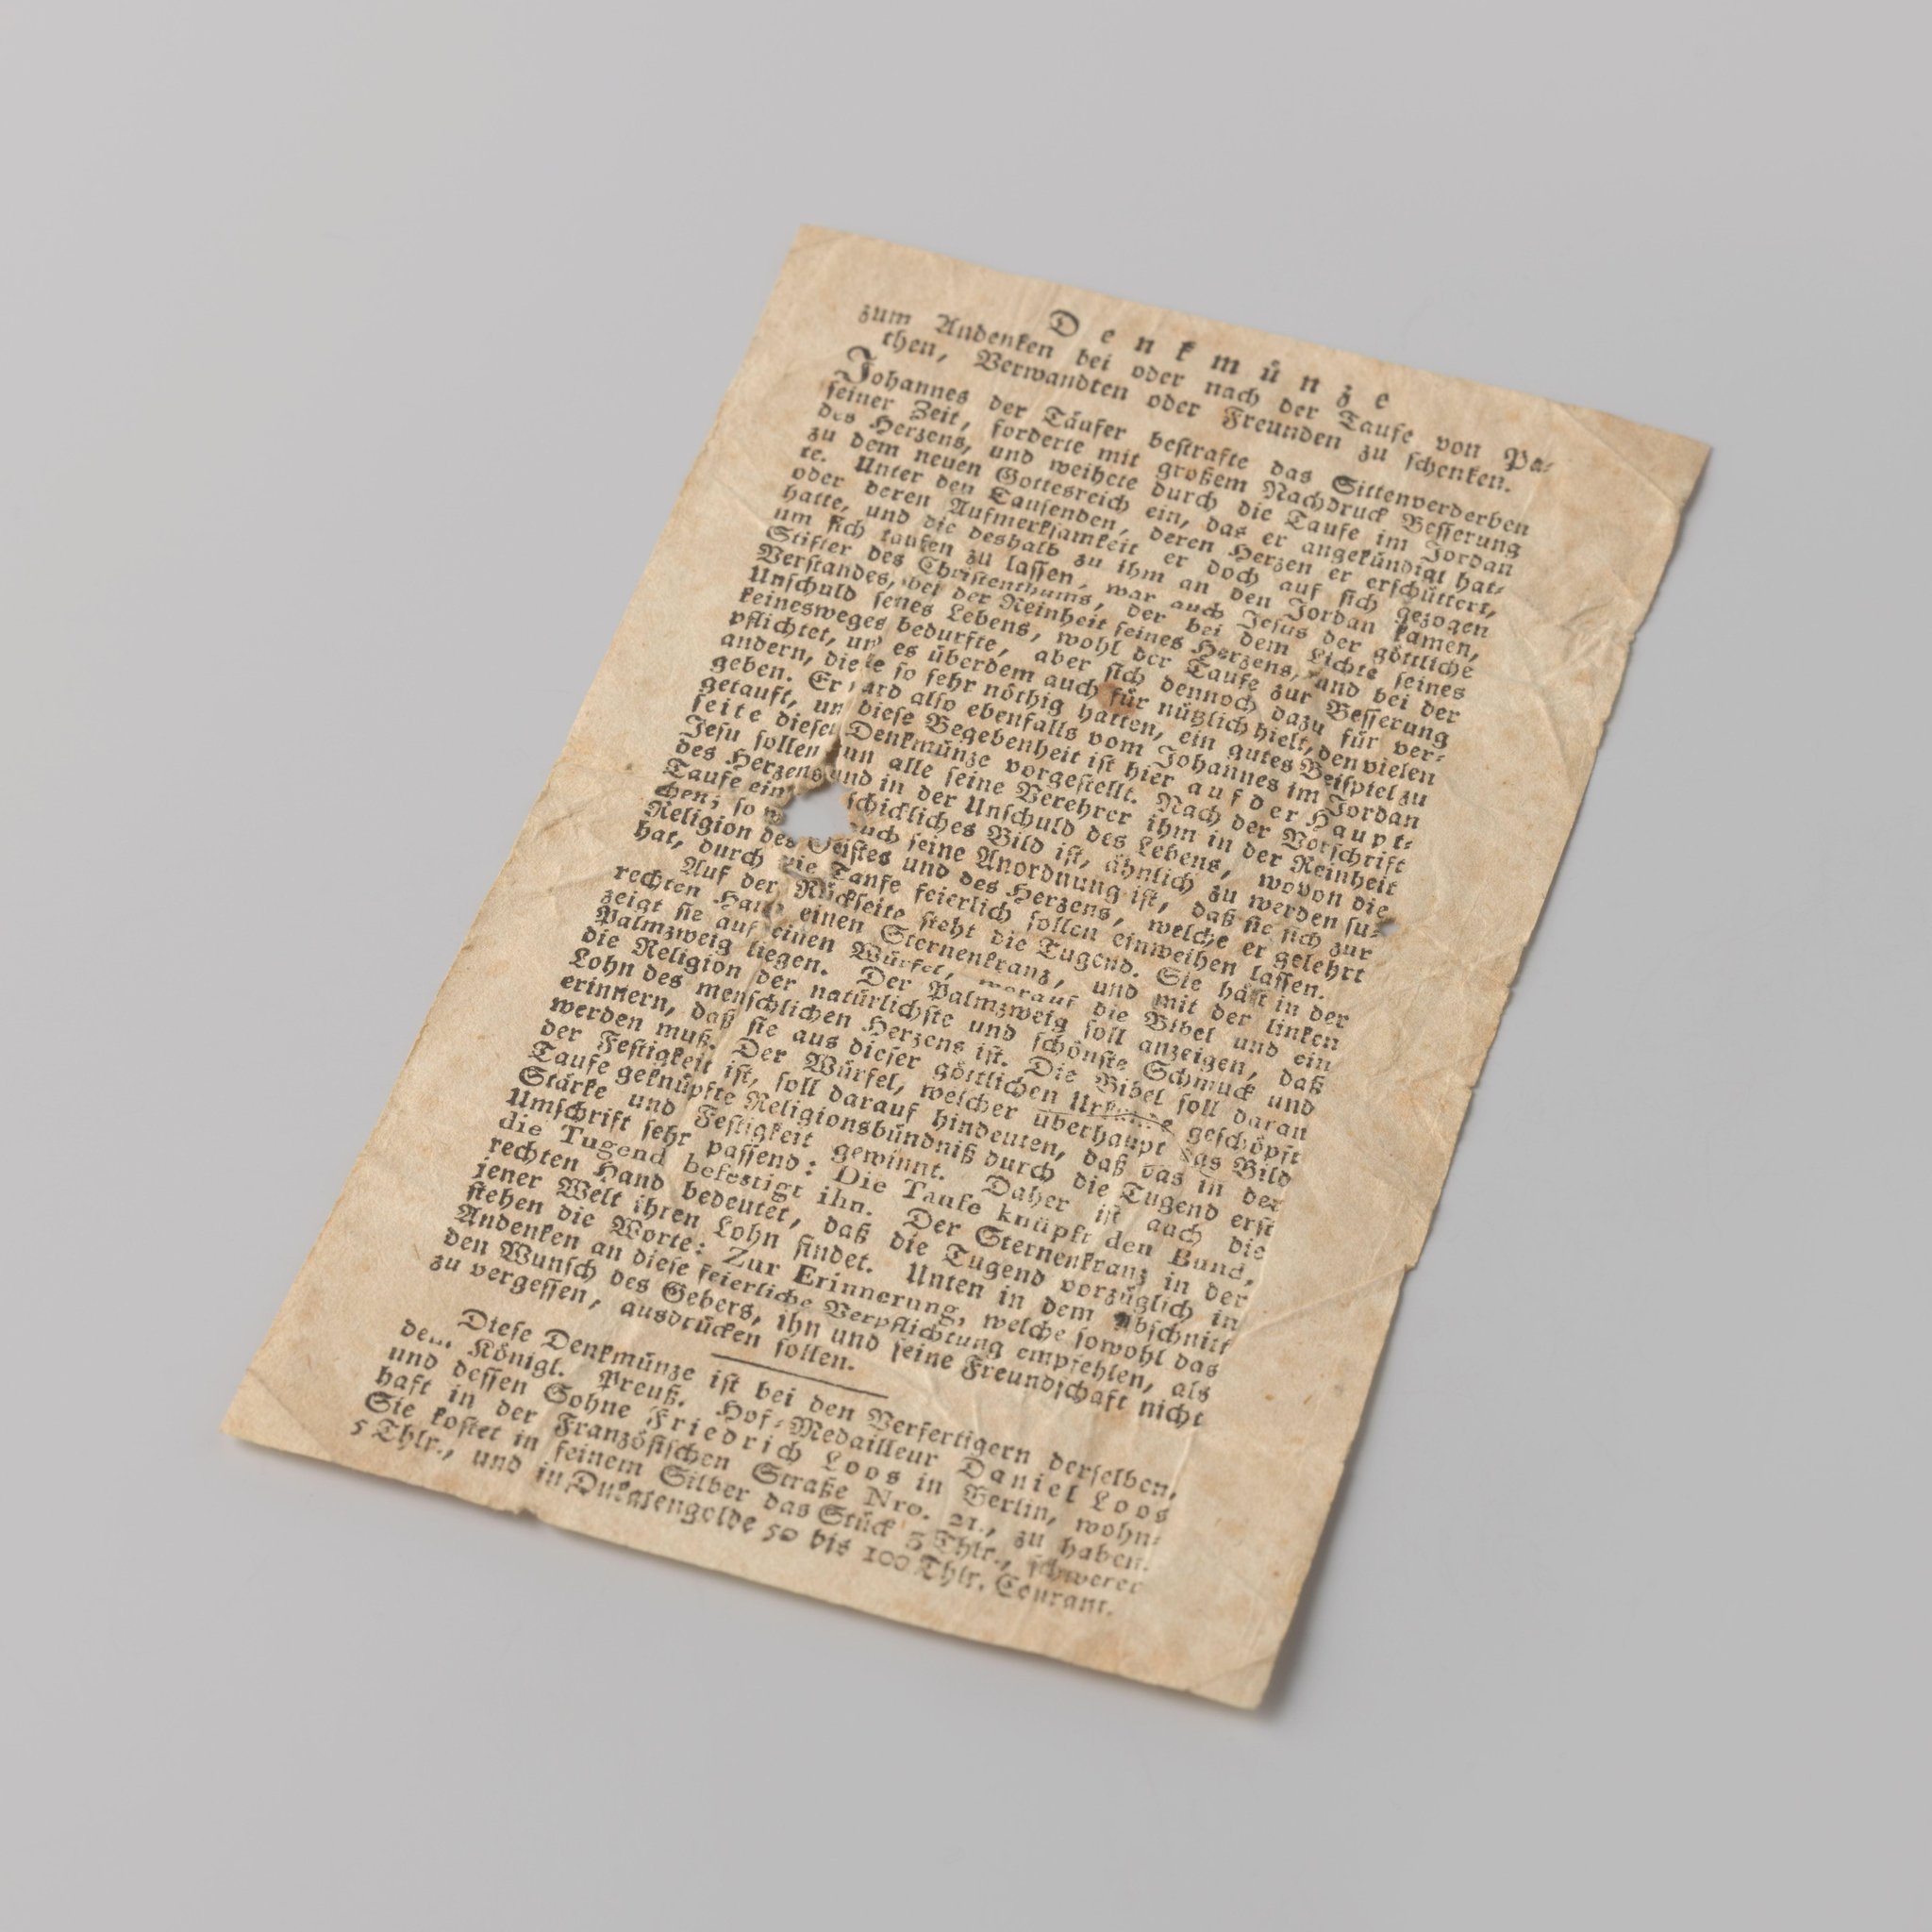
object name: penningverklaring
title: Verklaring van de penning Pathengeschenkt van de firma Loos te Berlijn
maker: daniel friedrich loos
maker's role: medailleur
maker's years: 1735-1819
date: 1775-1825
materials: paper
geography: berlin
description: Vel papier met gedrukte beschrijving van de betreffende penning.